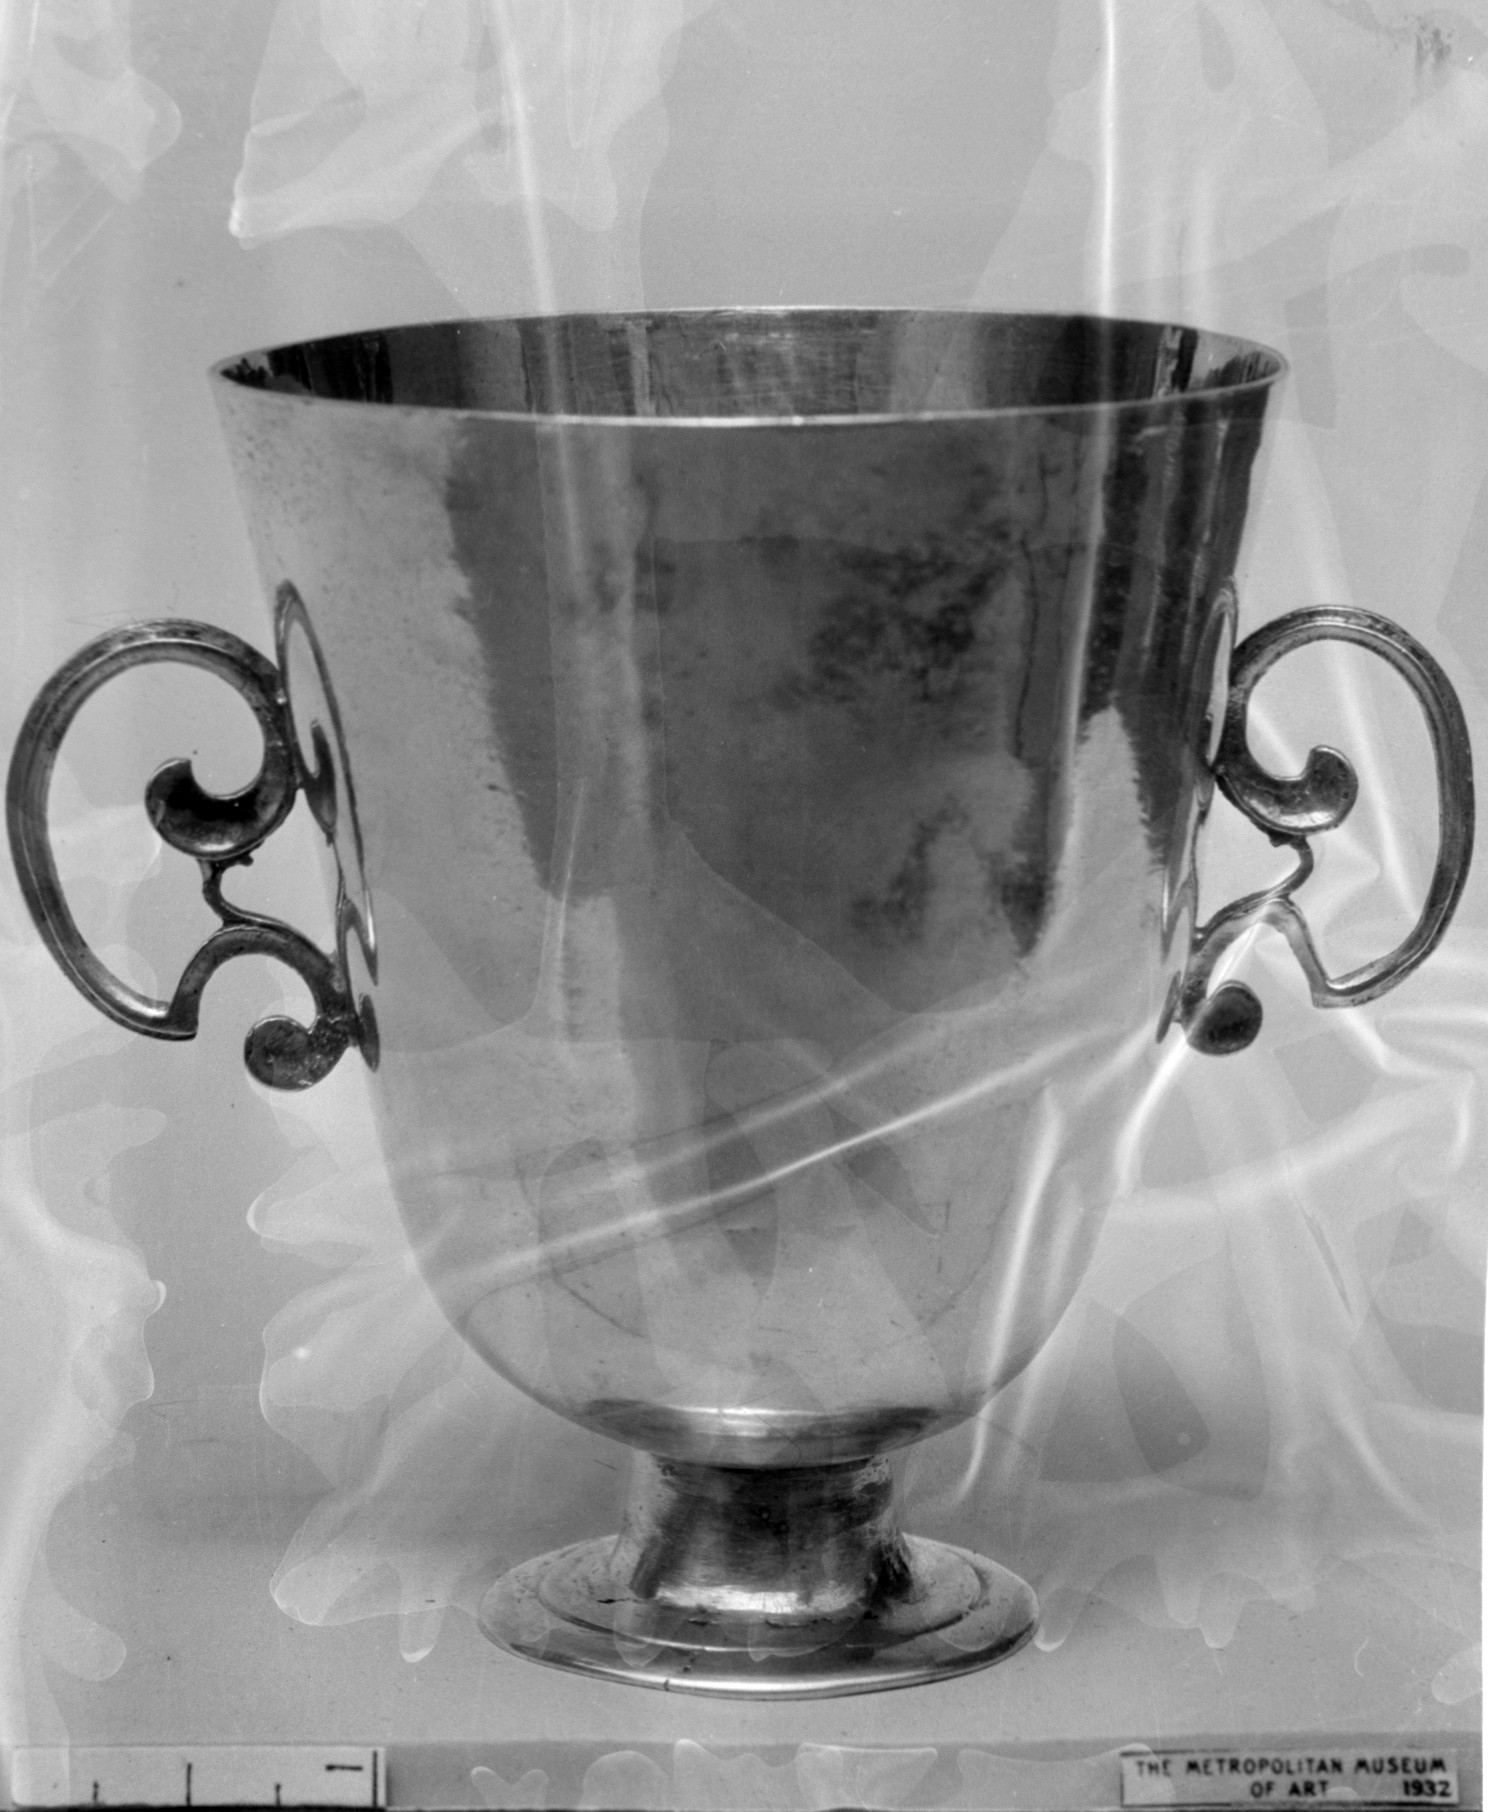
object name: cup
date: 1601-1700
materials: silver gilt